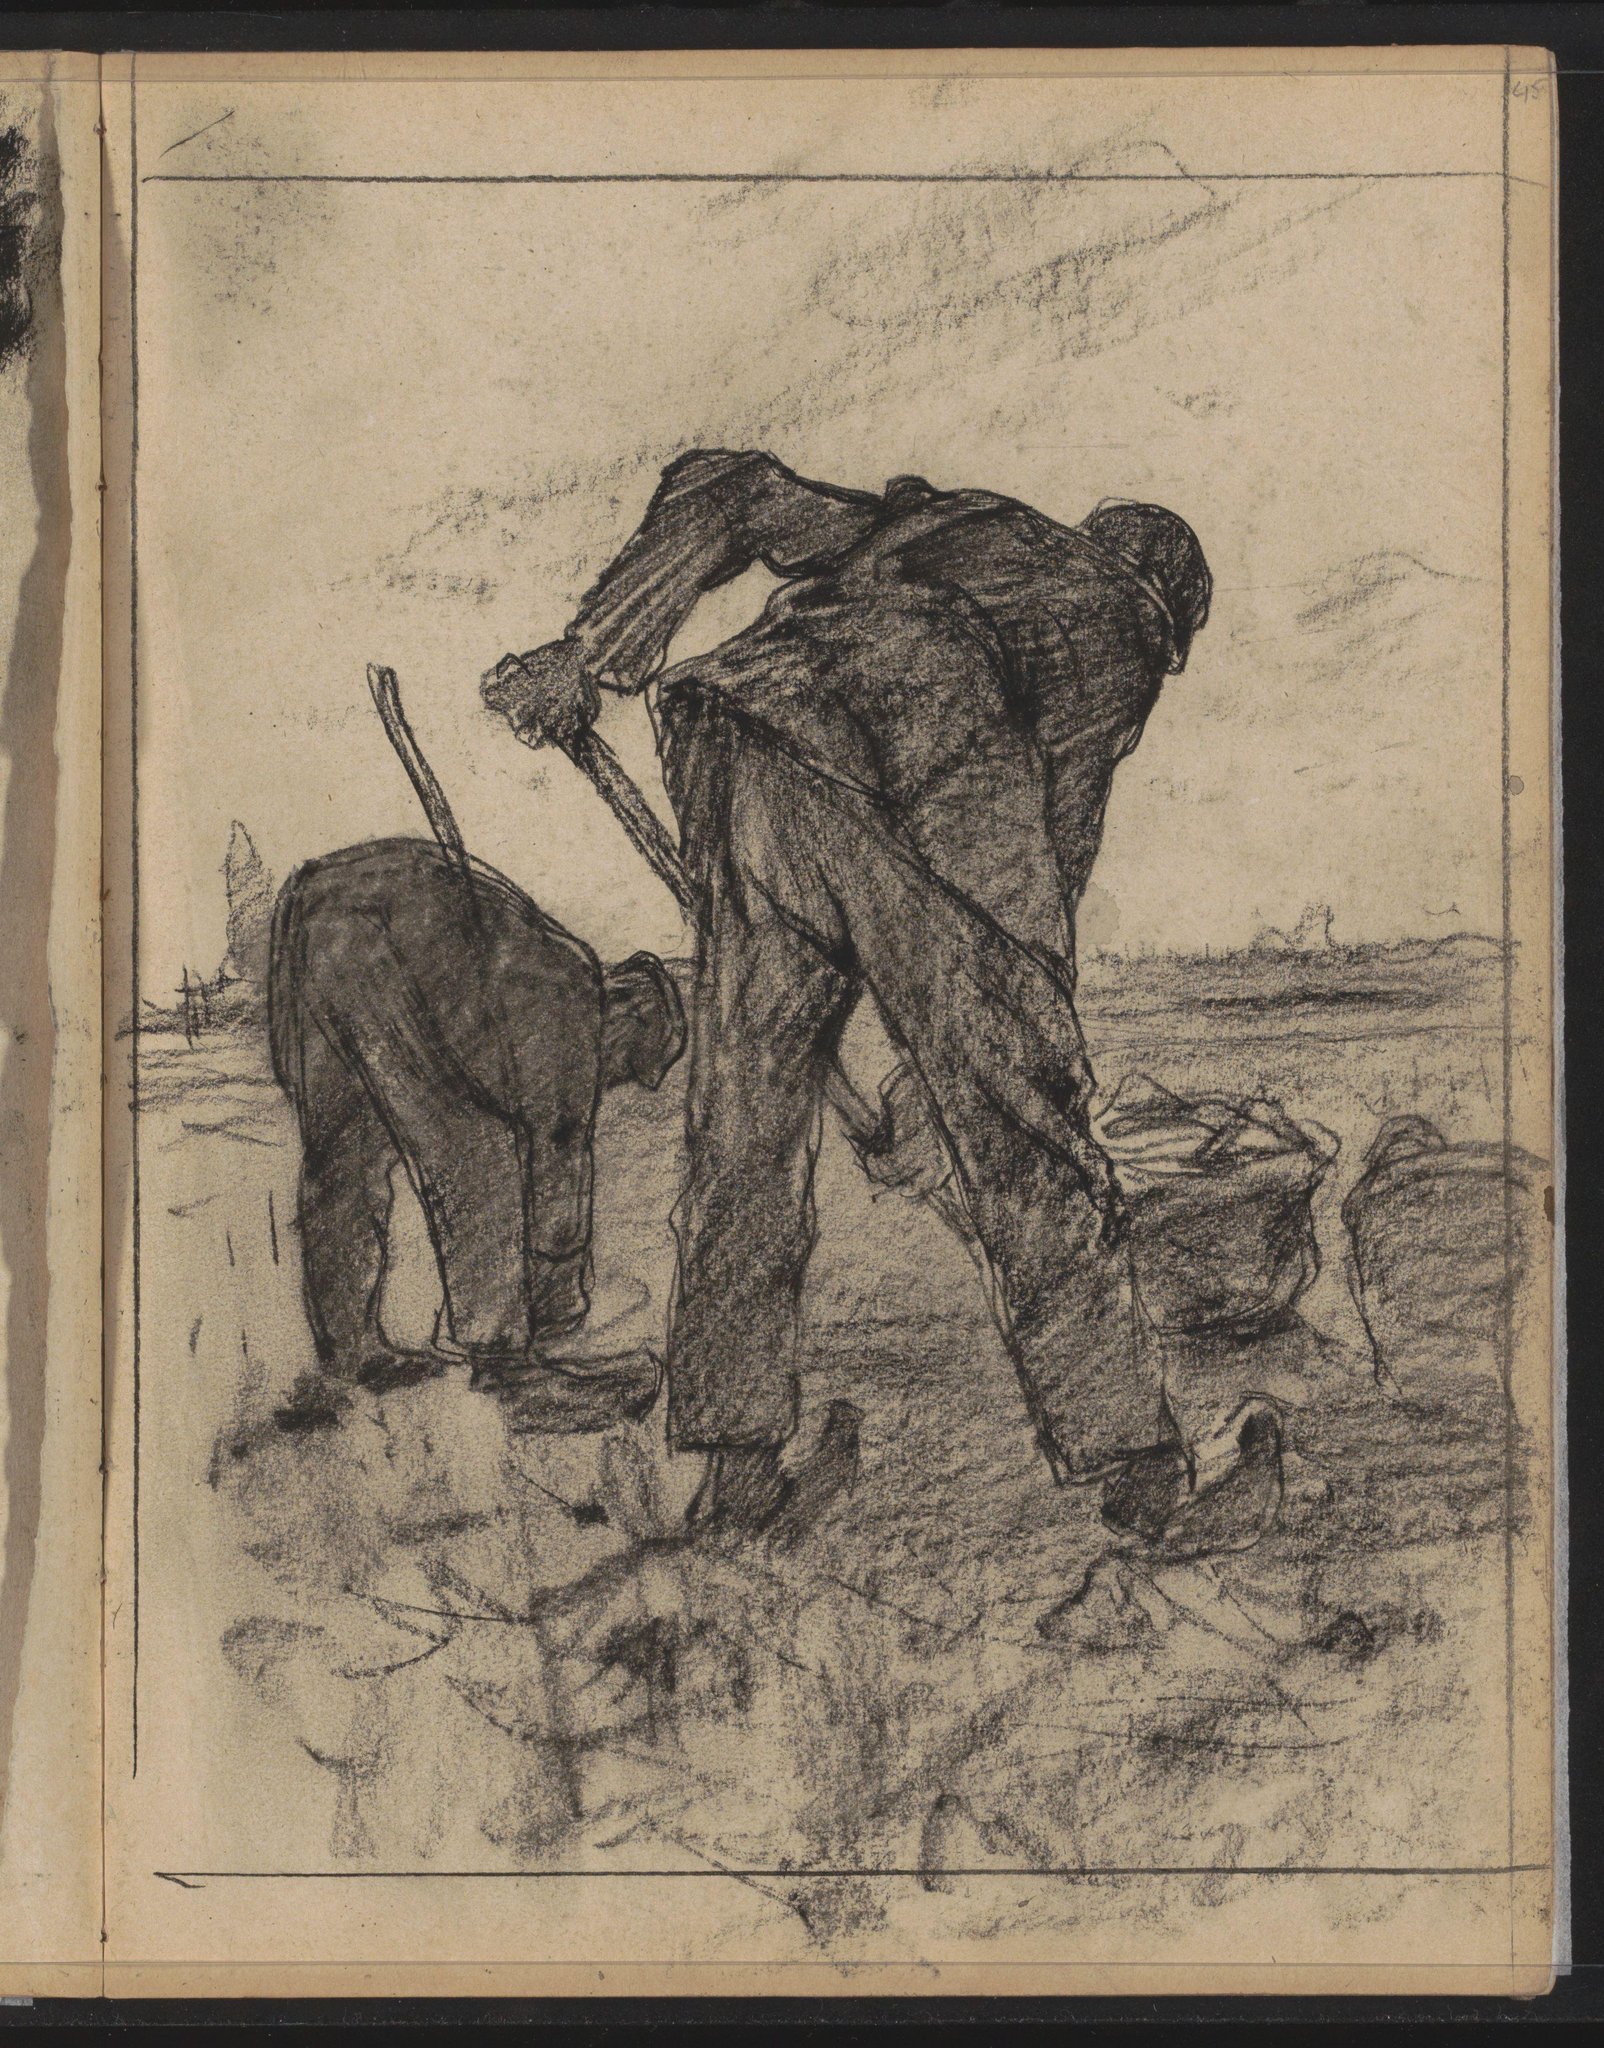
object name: sketchbook leaf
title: Aardappelrooiers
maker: willem witsen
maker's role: draughtsman, painter, print maker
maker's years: 1860-1923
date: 1887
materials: chalk, paper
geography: ewijkshoeve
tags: farmers, cultivated land, reaping, picking, mowing ~ harvest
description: Voorstudie voor de ets 'Aardappelrooiers', ca. 1887.